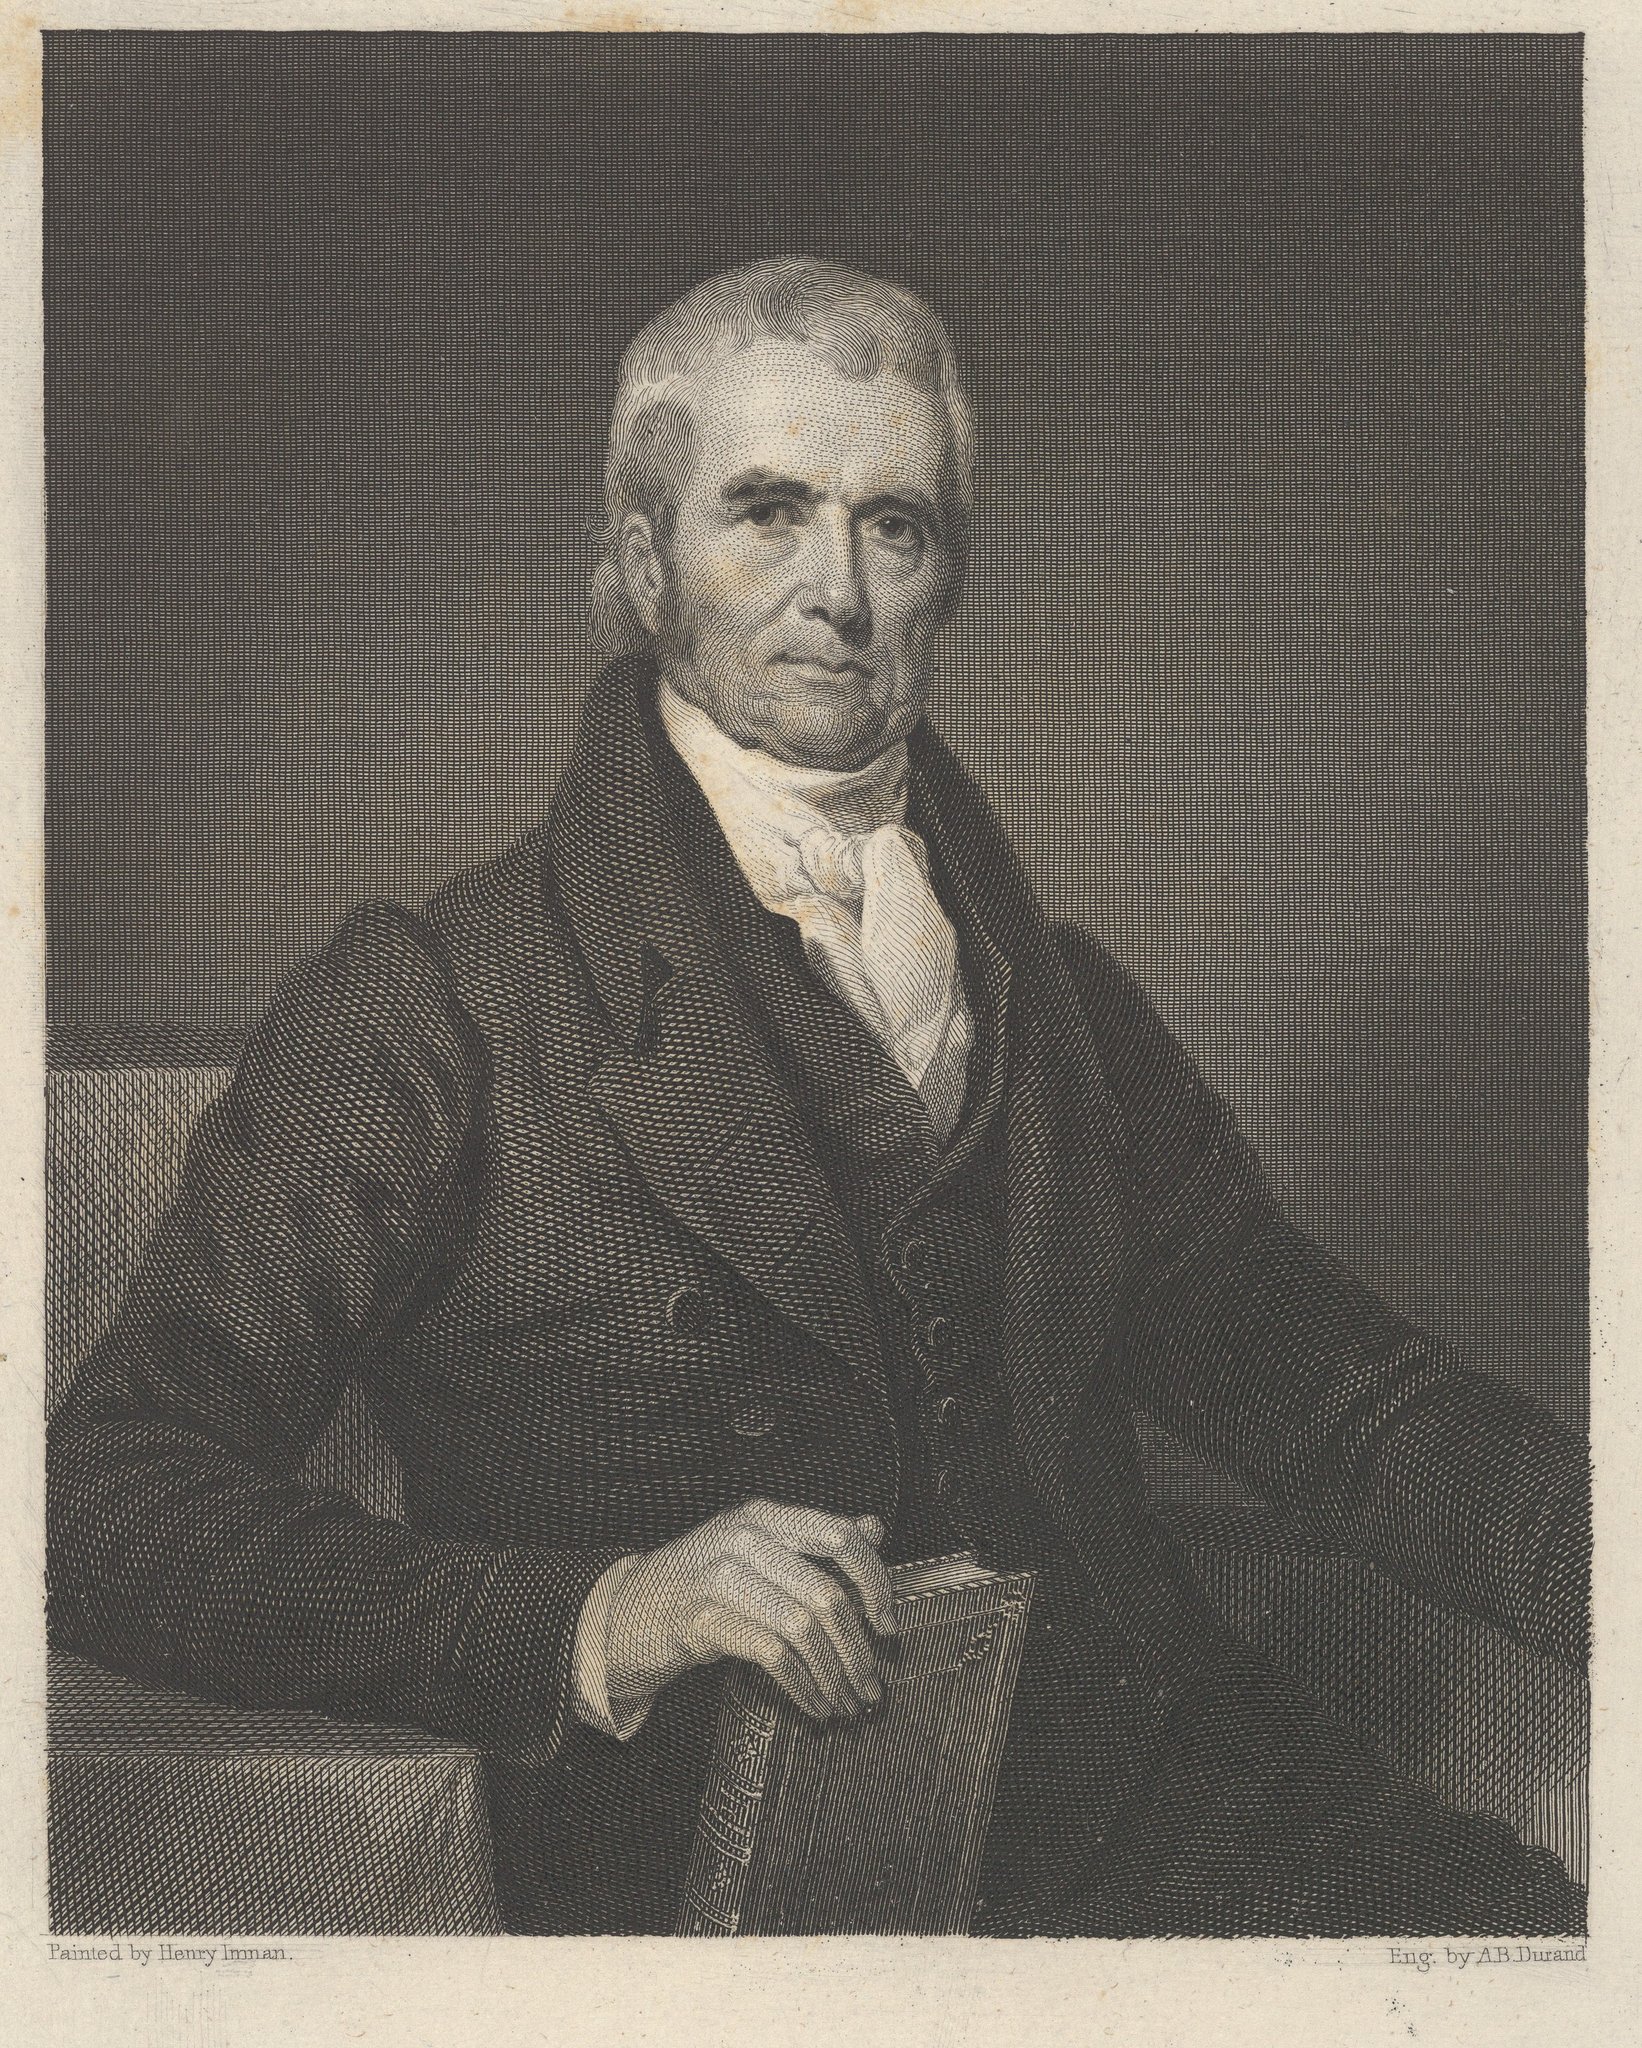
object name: print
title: Chief Justice John Marshall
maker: asher brown durand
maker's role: artist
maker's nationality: american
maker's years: 1796-1886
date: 1833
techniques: engraving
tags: men,portraits